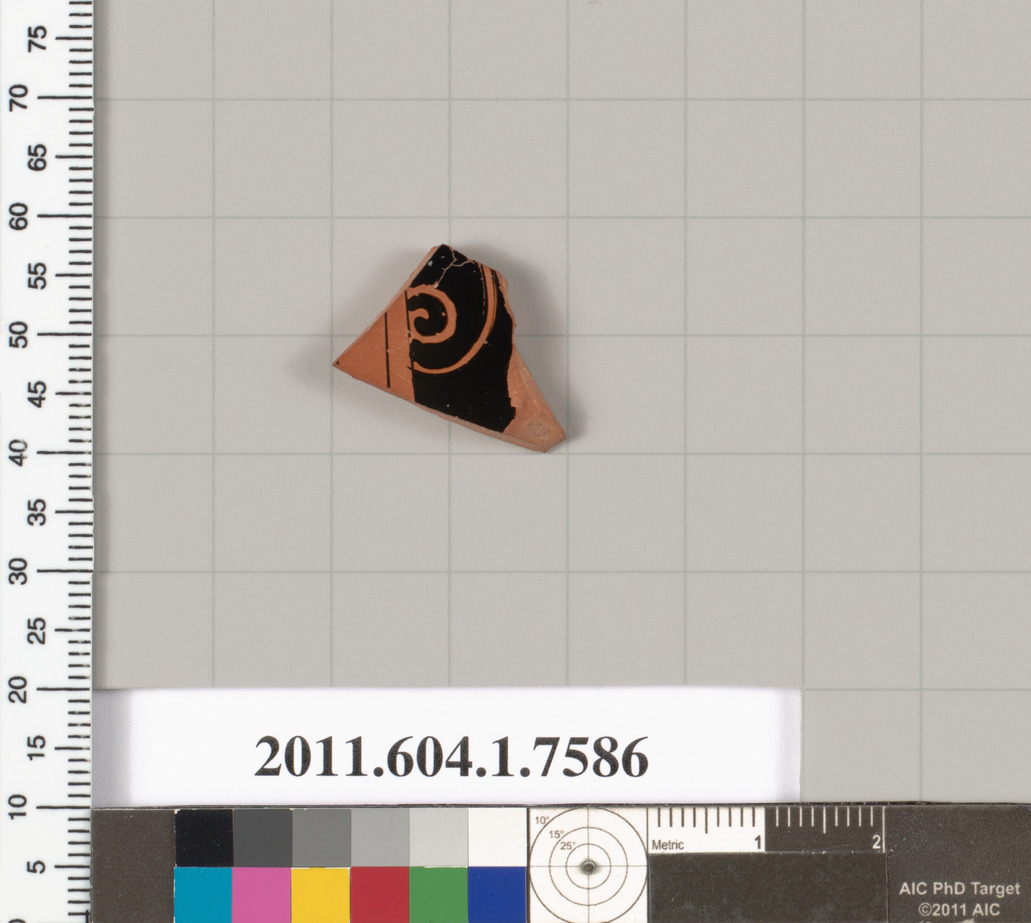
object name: kylix fragment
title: Terracotta fragment of a kylix (drinking cup)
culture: greek, attic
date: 460-450 BCE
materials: terracotta